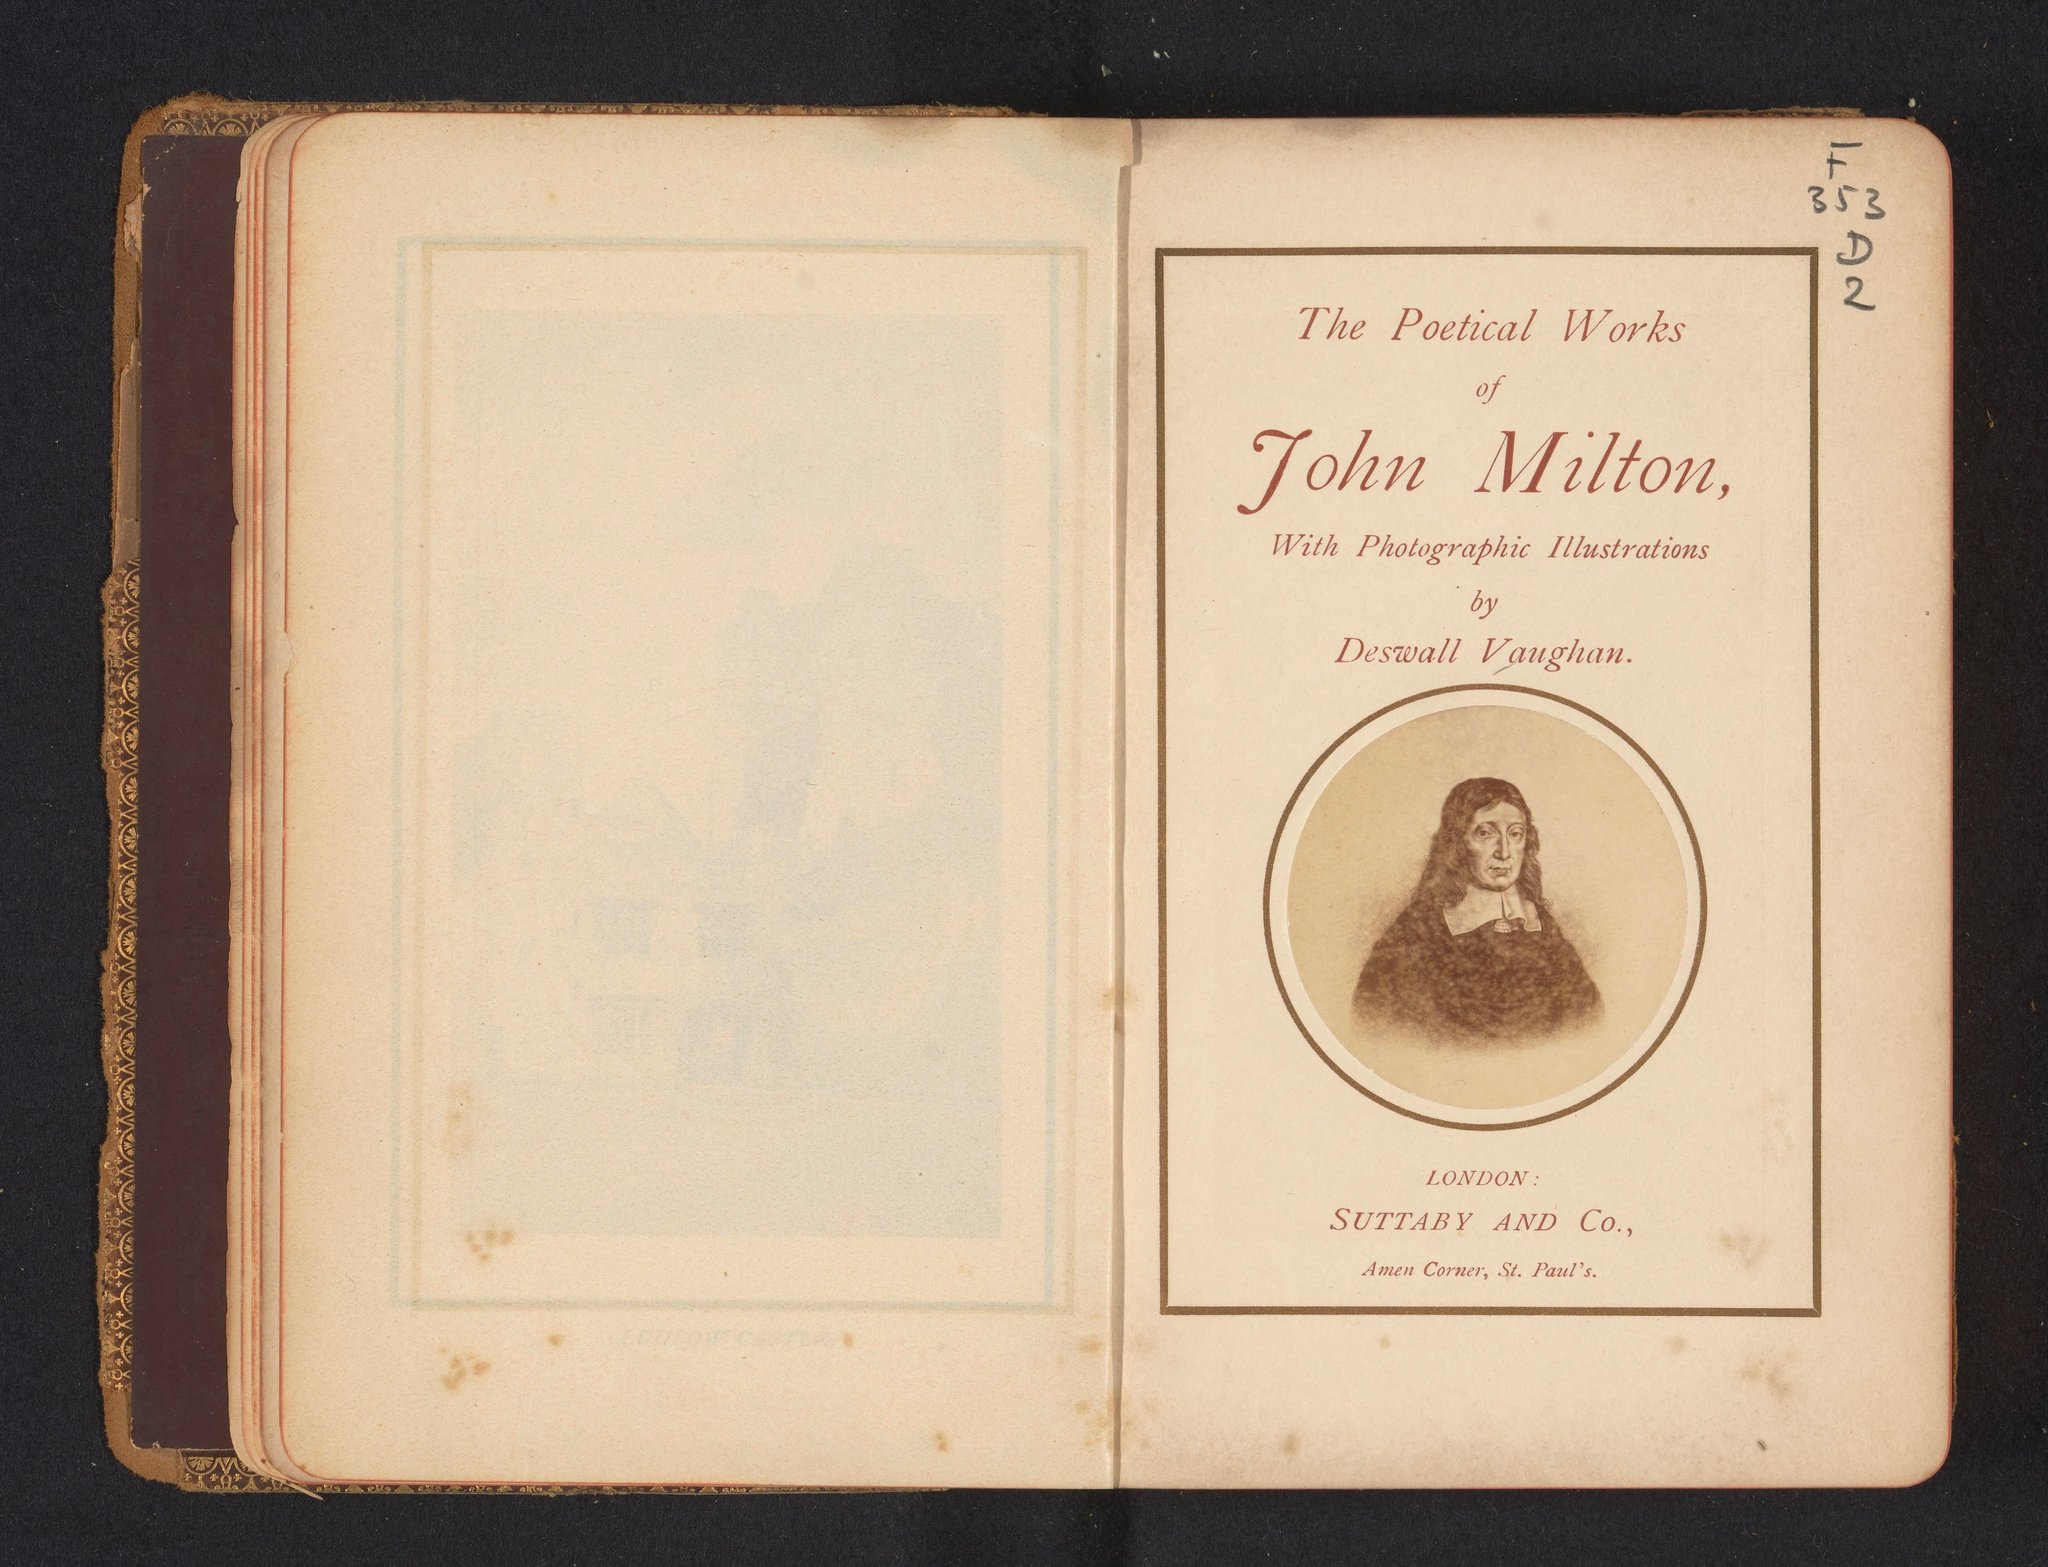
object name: book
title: The poetical works of John Milton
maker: john milton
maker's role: dichter, schrijver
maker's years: 1608-1674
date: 1885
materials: linen, paper, photographic support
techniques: albumen print, printing, marbled paper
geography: london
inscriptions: name: ‘ex libris SFJ’, inscription: ‘Queenie with love from Laddie 15th May 86’